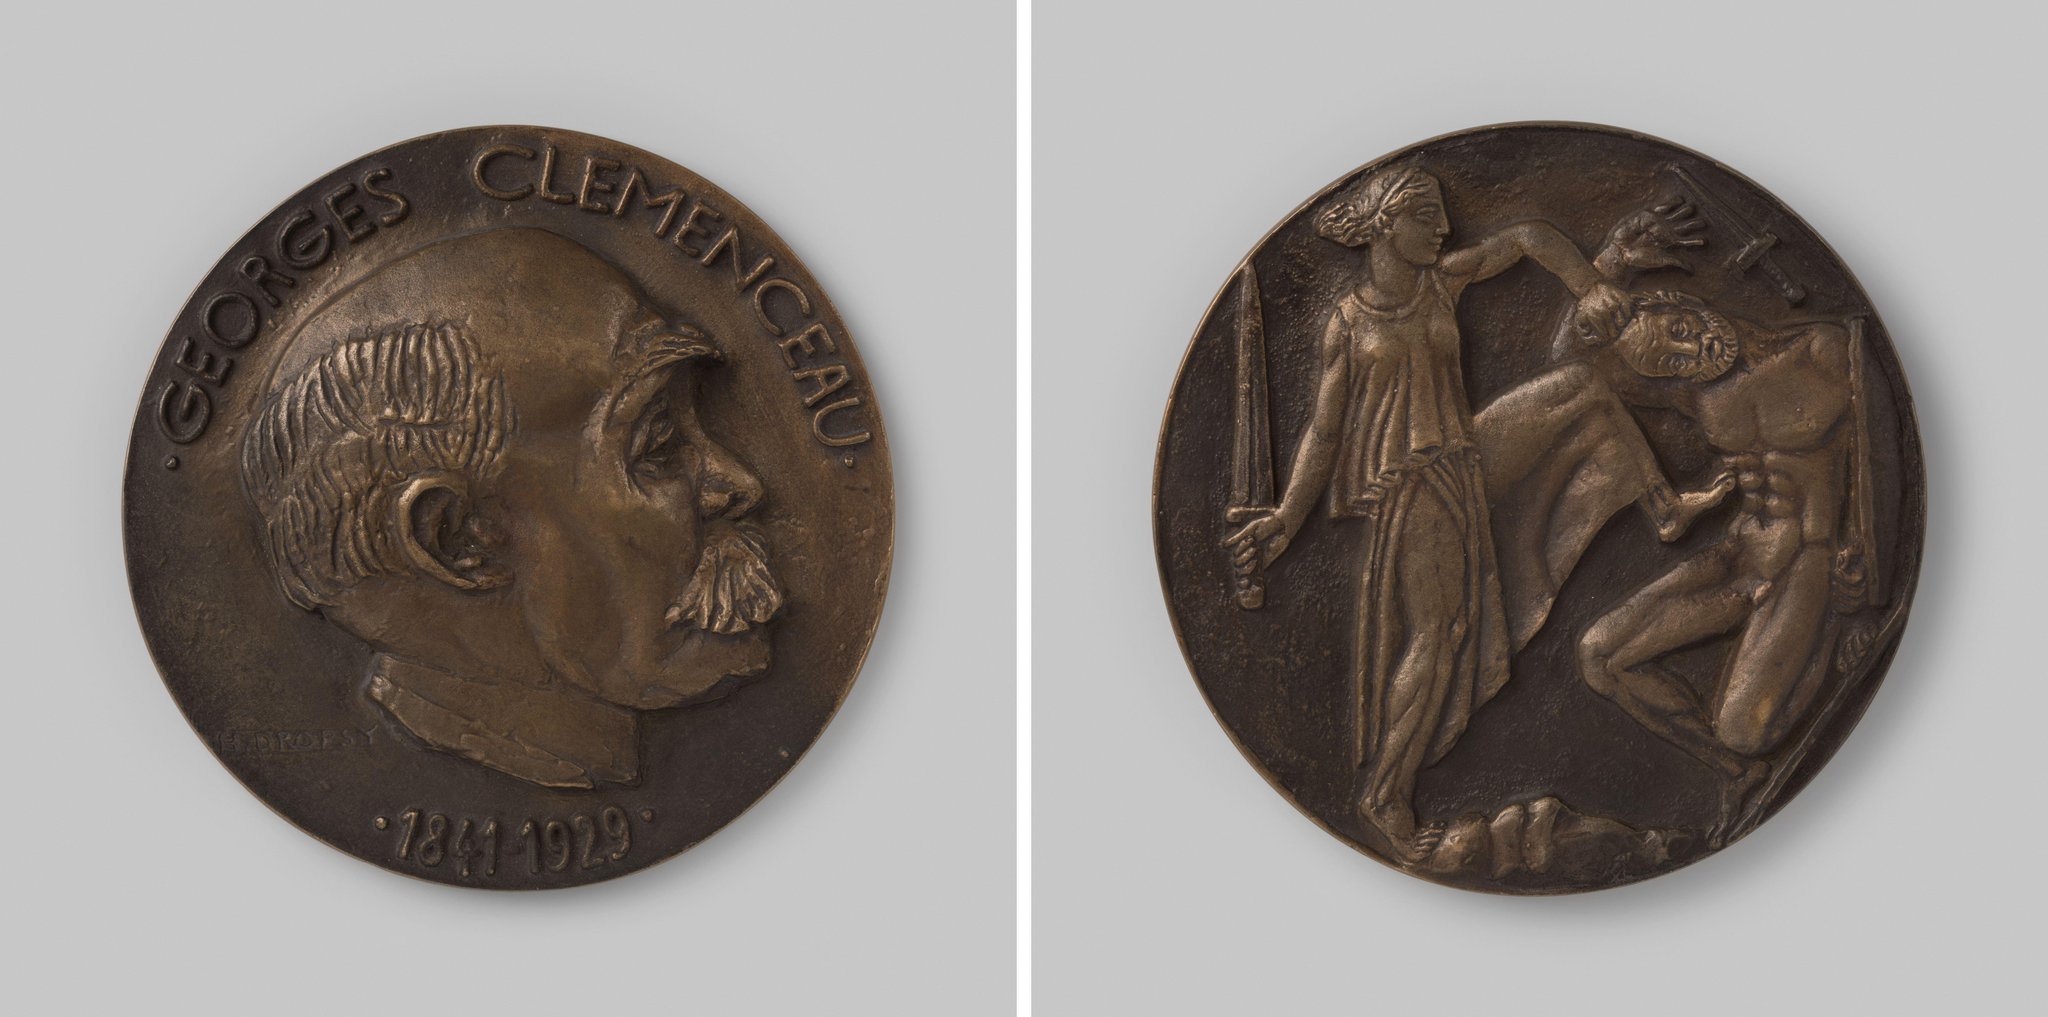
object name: history medal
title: Overlijden van Georges Clemenceau 1929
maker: henri dropsy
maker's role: medailleur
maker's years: 1885-1969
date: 1929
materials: bronze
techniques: casting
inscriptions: number: ‘(vierkant merk) 132’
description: Bronzen penning, op de voorzijde het portret van Clemenceau naar rechts met omschrift, op de keerzijde een vrouw met zwaard die een antieke soldaat overwint.